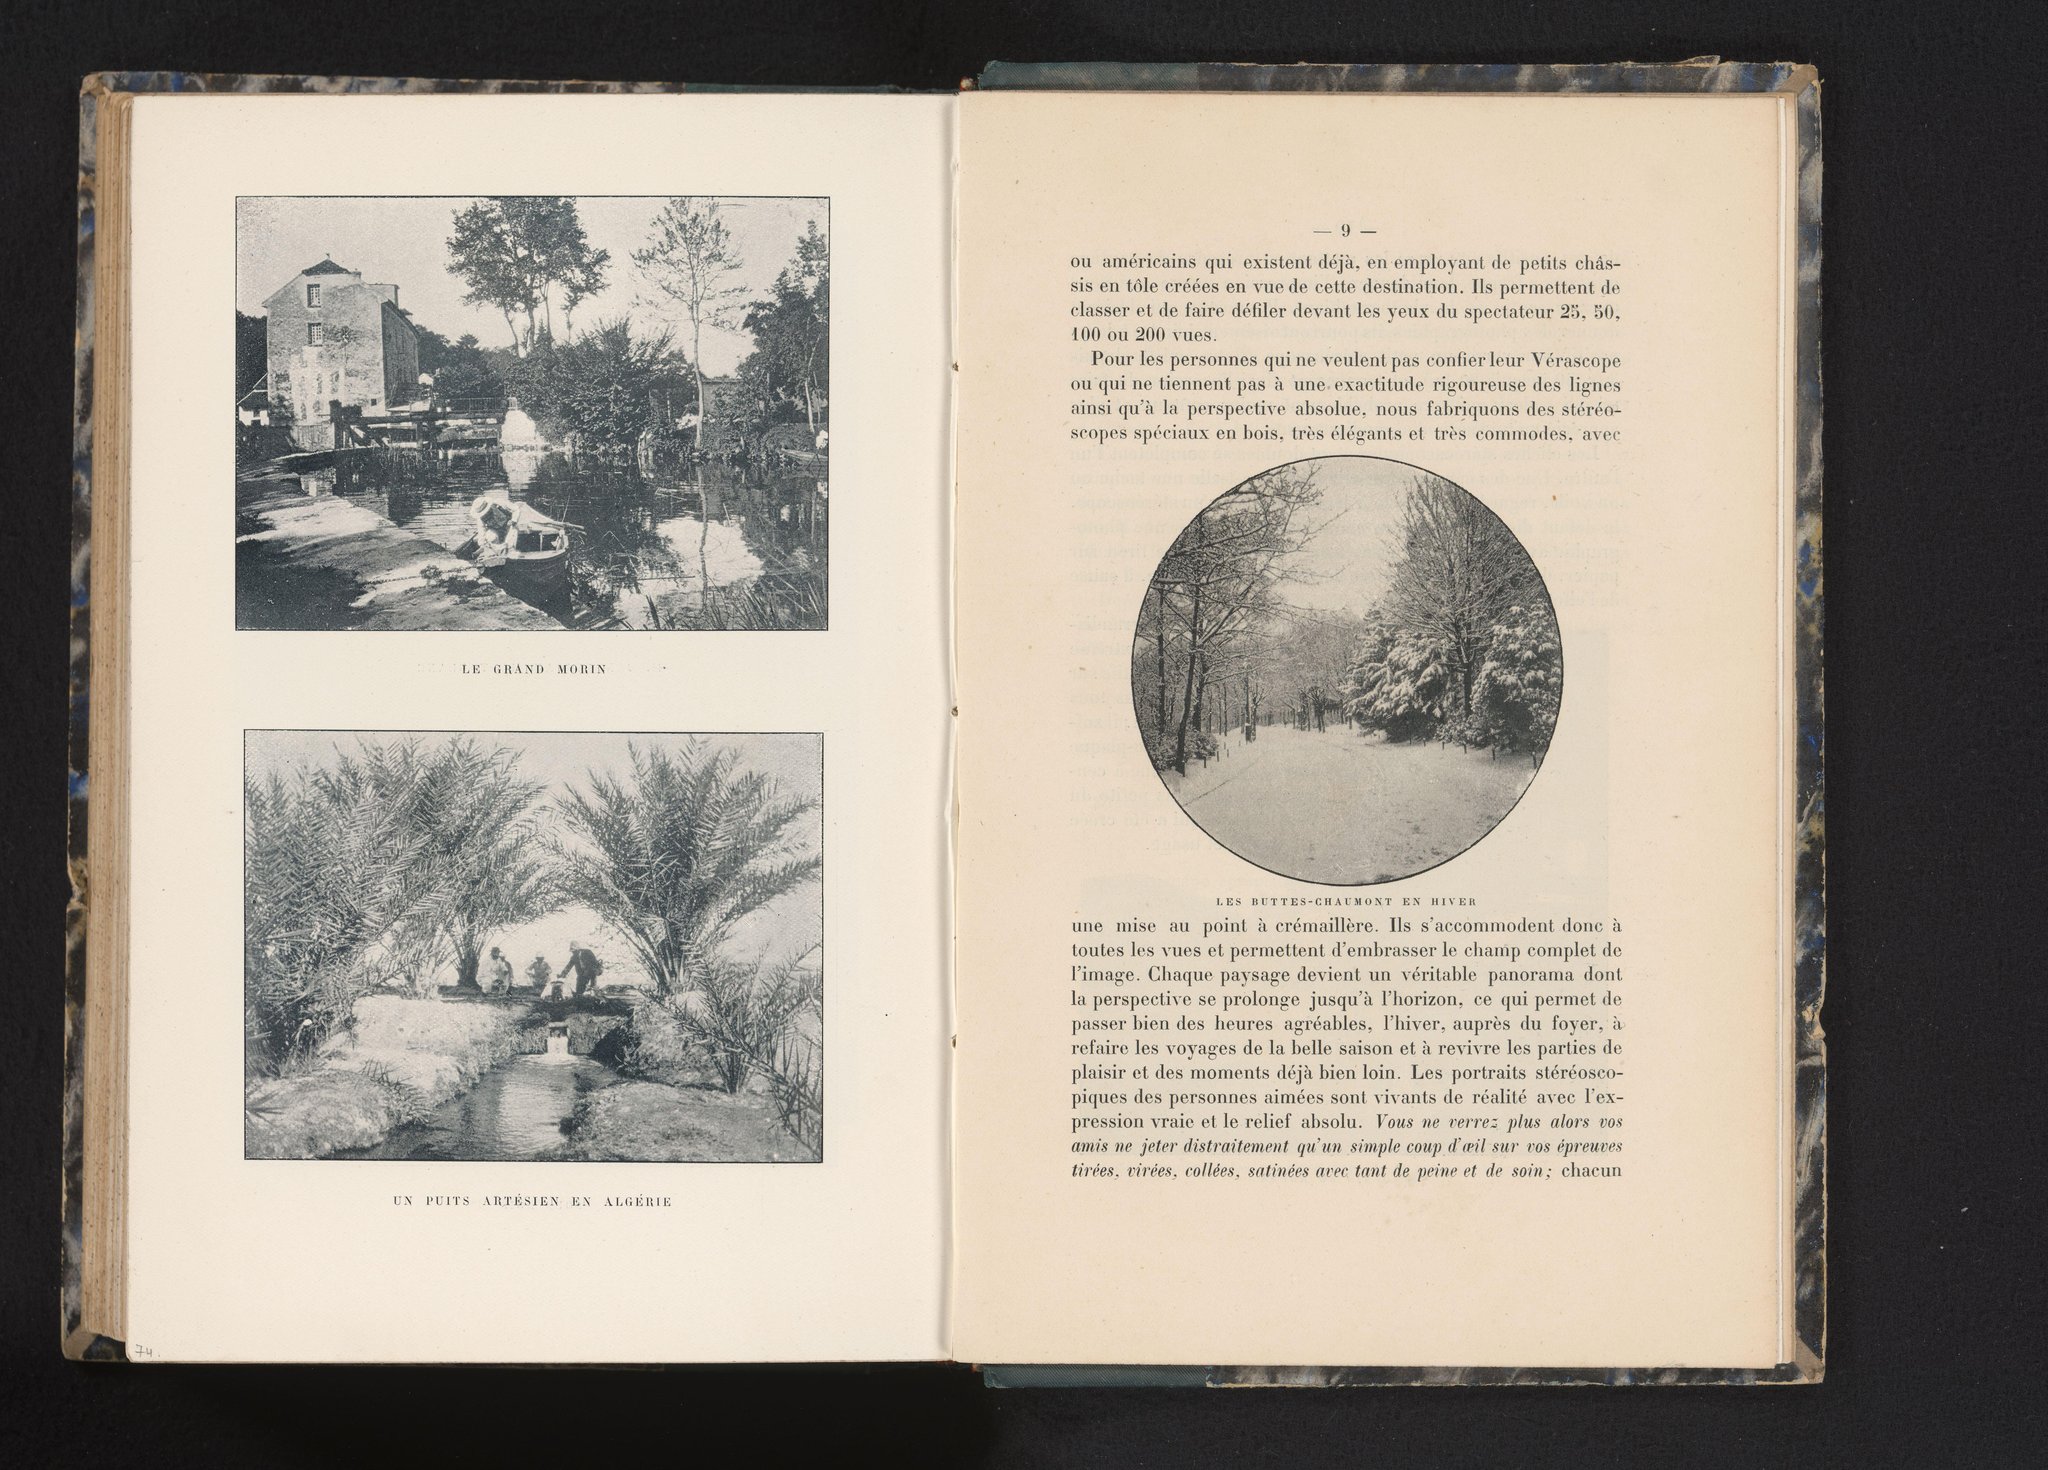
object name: photomechanical print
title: Le Grand Morin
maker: Anonymous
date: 1891-1896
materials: paper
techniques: autotype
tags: river, adult man (+ four persons), spring (fluids extracted from the earth)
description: Prenten tegenover pagina 9 van het supplement A l'Amateur Photographe achterin het boek.